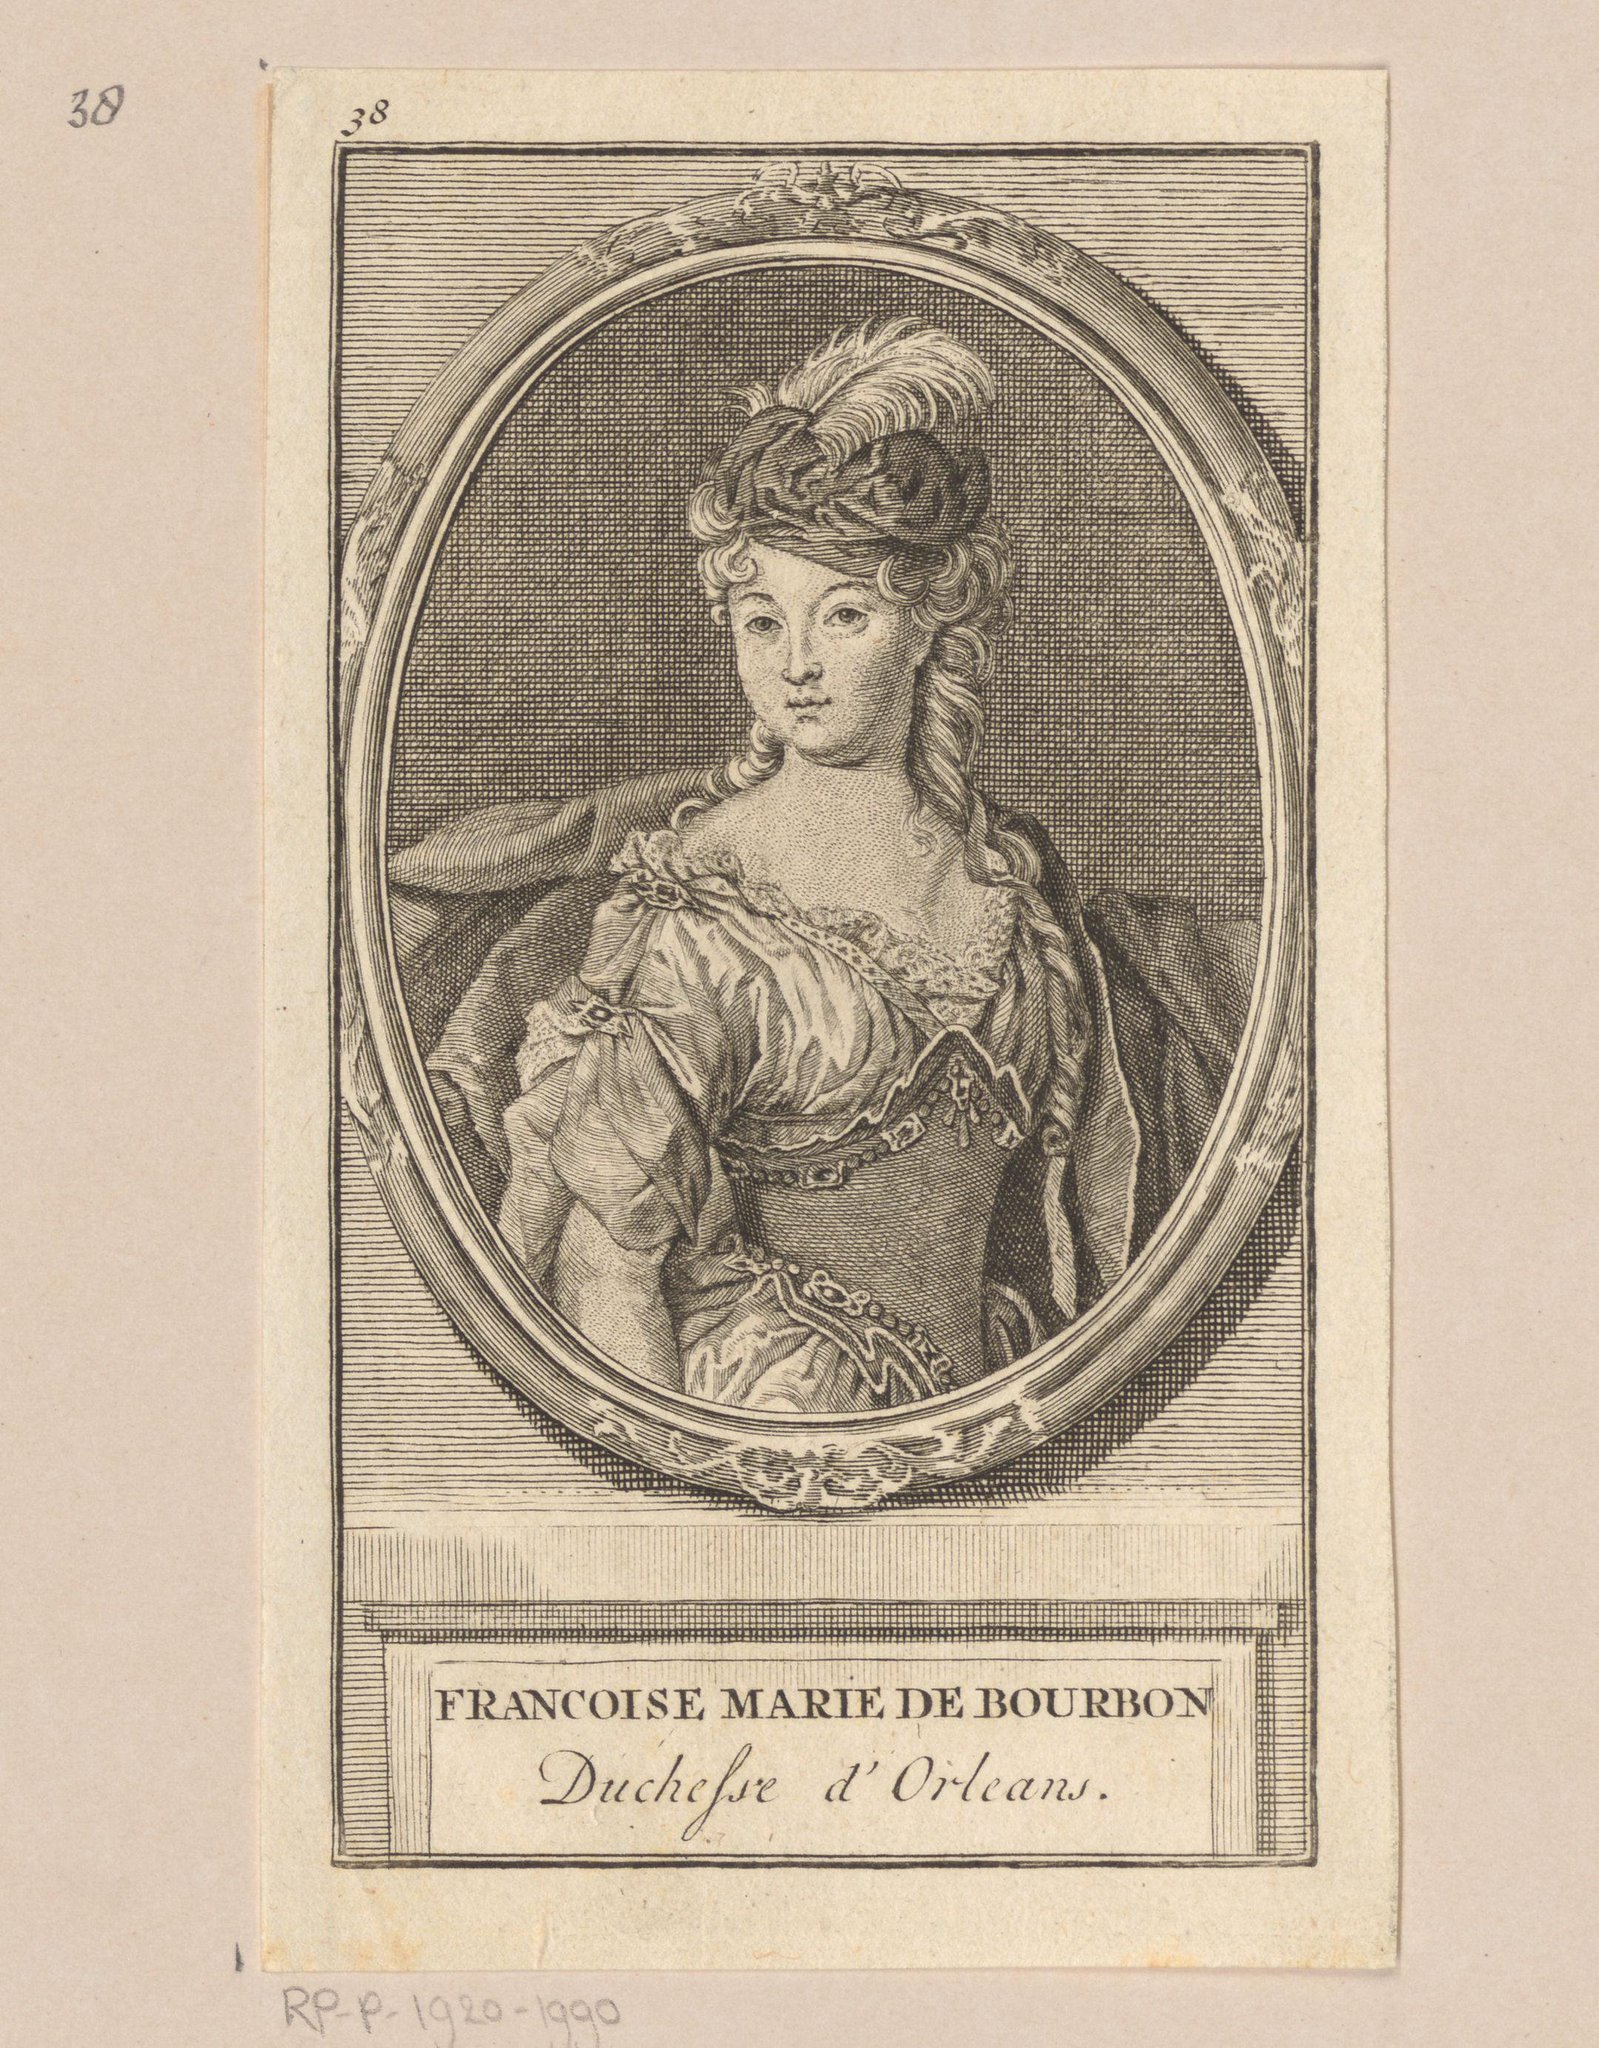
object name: print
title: Portret van Françoise Marie de Bourbon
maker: Anonymous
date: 1697-1799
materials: paper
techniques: engraving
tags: historical persons - bb - woman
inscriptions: collector's mark: Lugt 2228